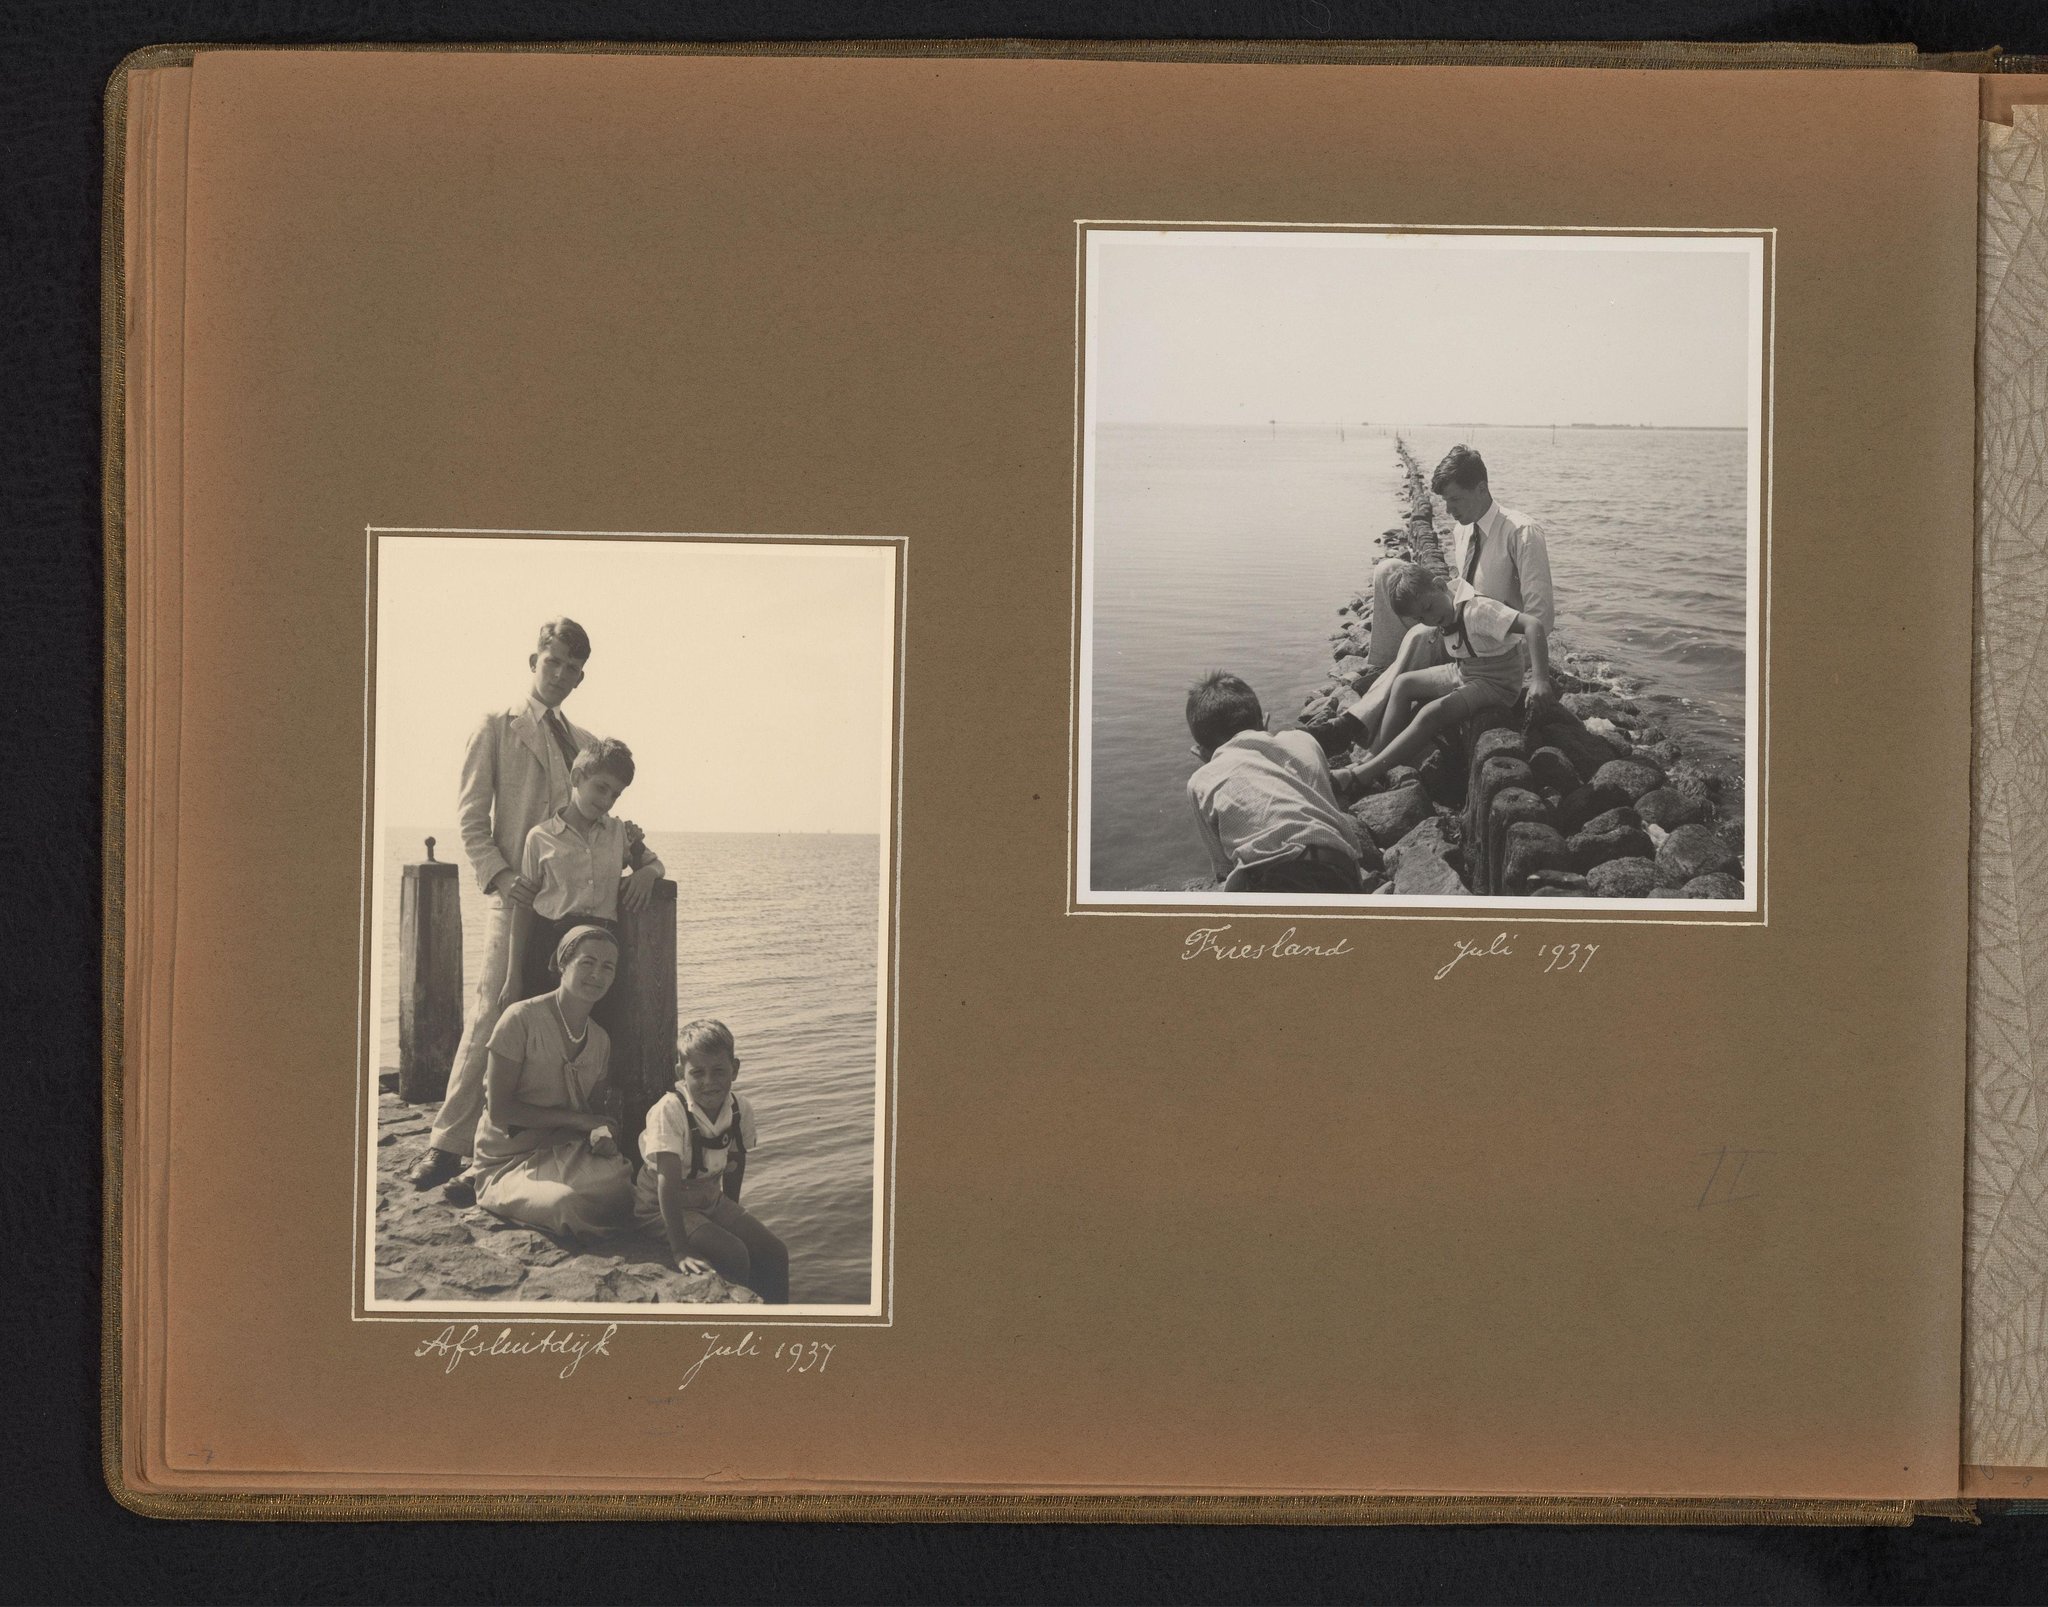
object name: photograph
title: Afsluitdijk, Friesland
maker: Anonymous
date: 1907-1937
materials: paper, cardboard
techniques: gelatin silver print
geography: friesland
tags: mother and son(s) (family group)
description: Deze foto's zijn onderdeel van een album.